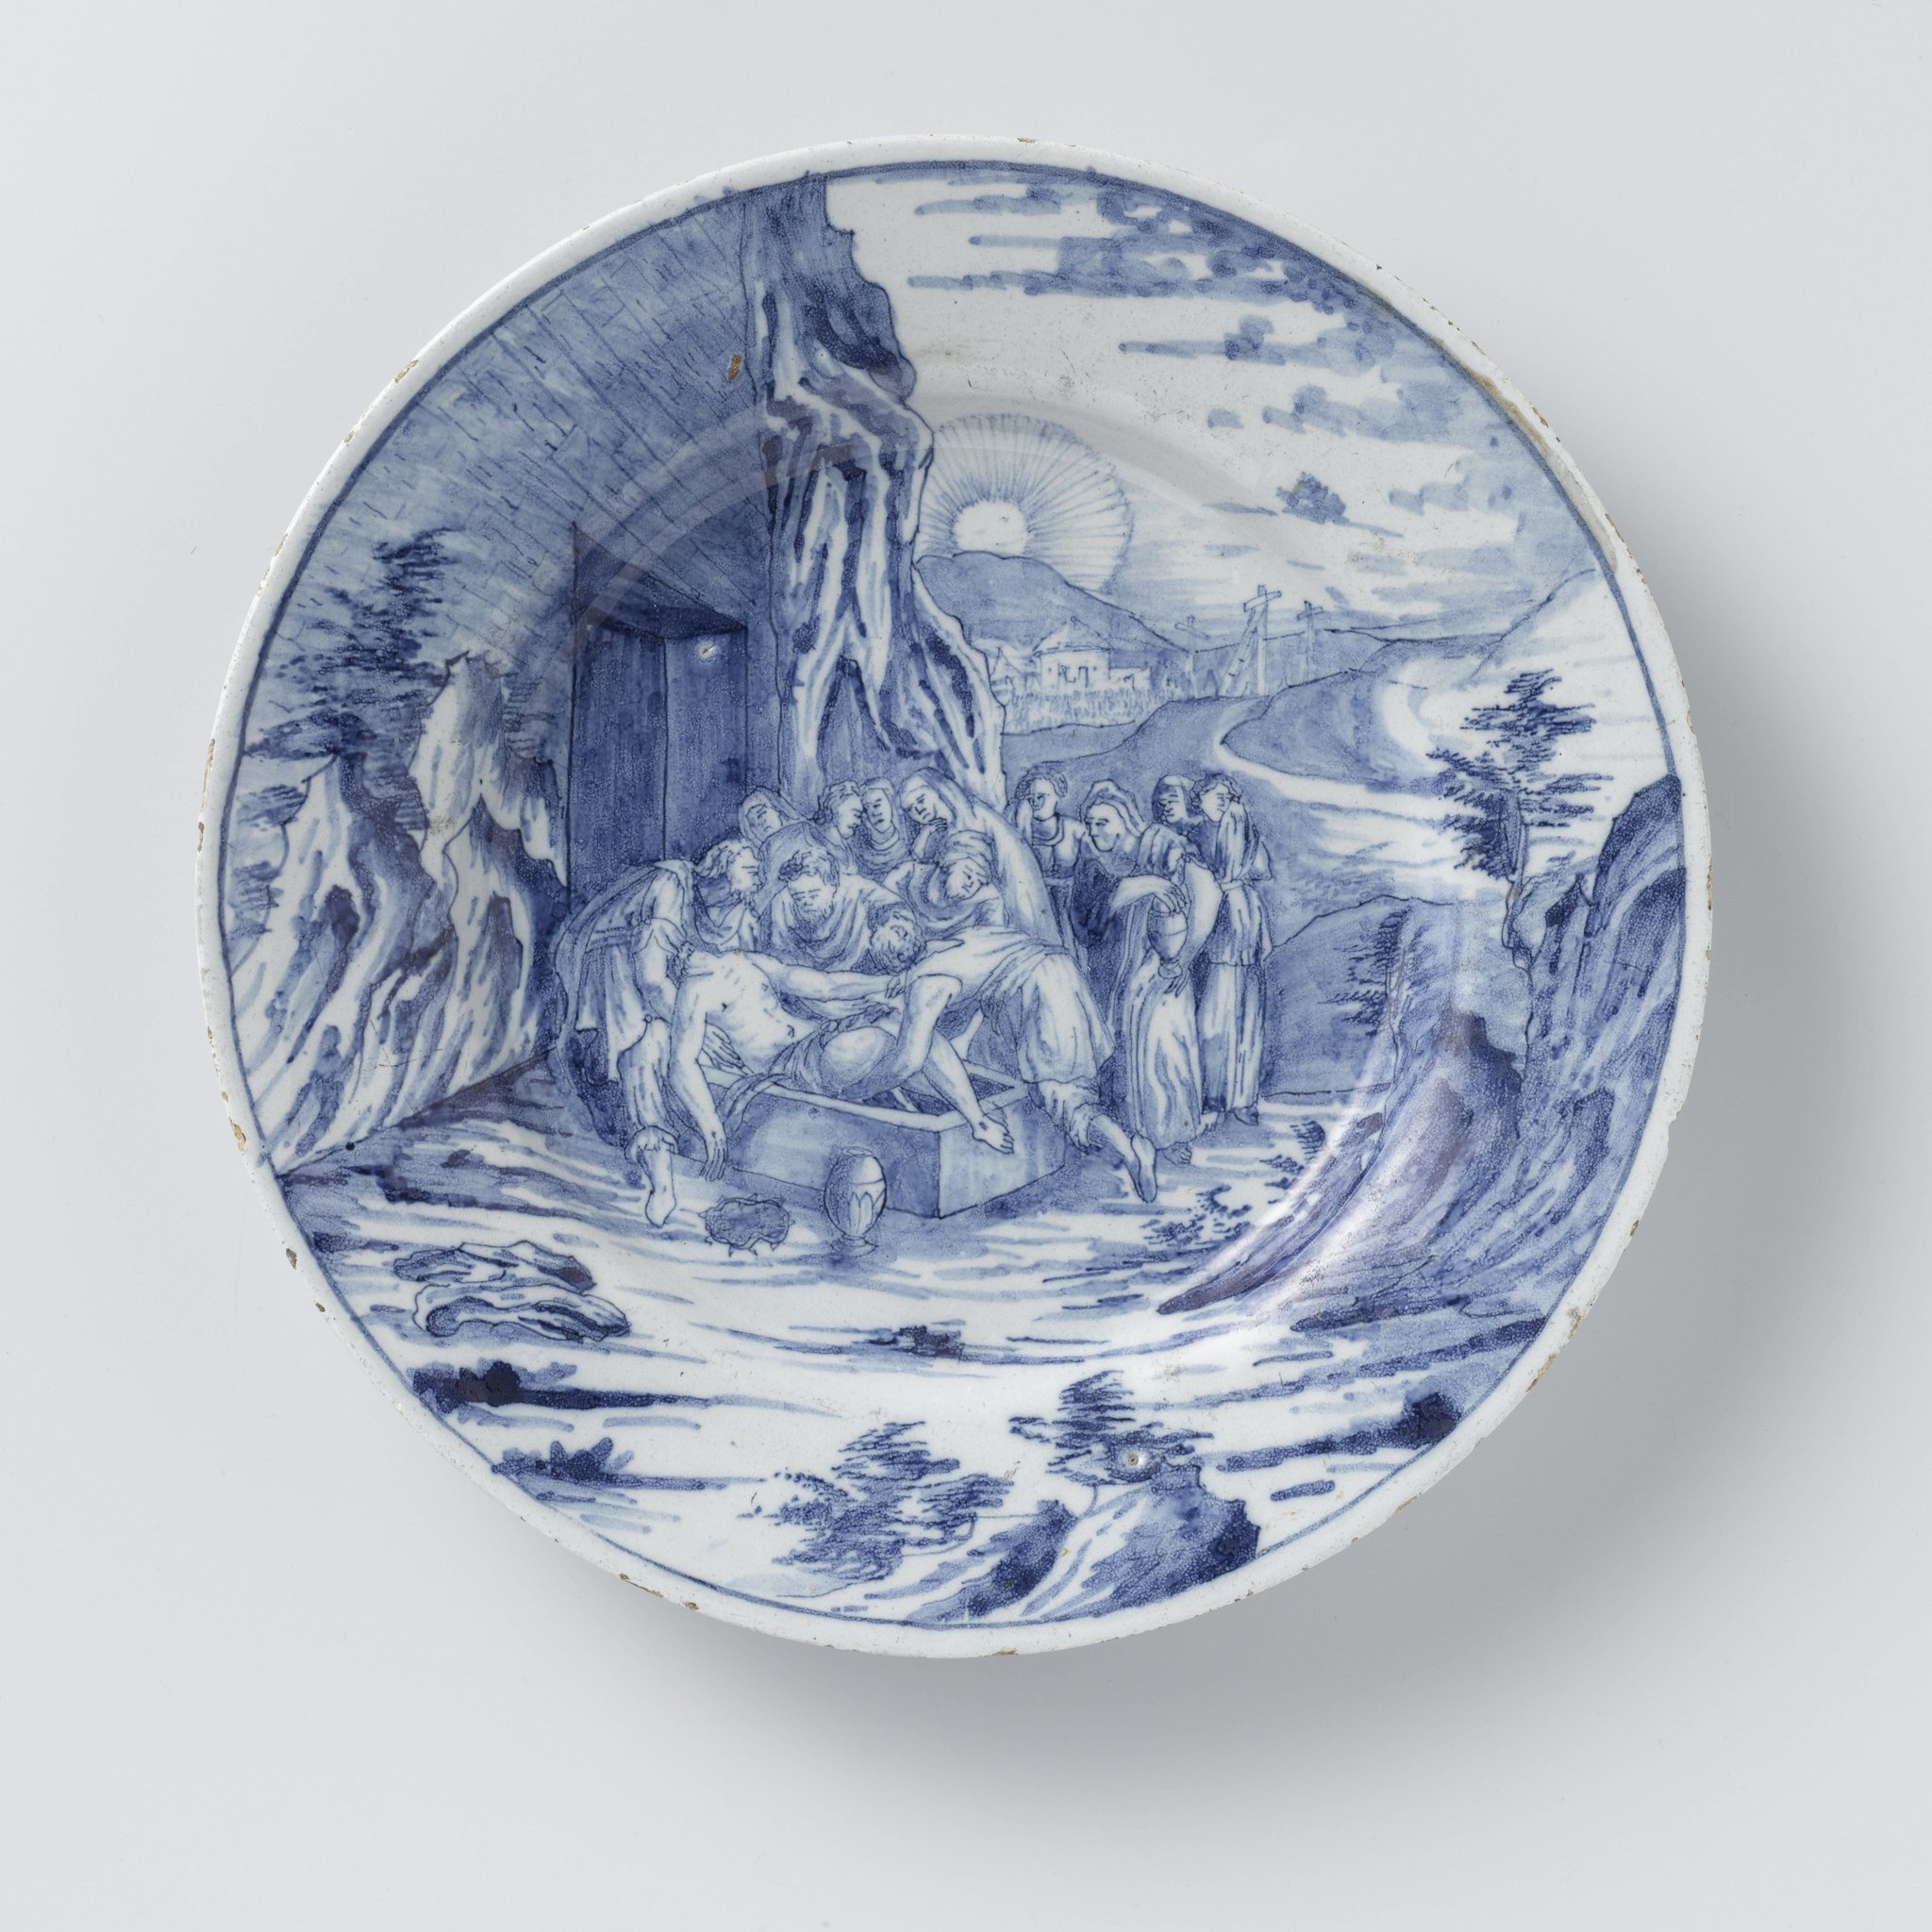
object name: plate dish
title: Bord van faïence met de graflegging van Christus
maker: Anonymous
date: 1750-1775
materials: faience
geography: delft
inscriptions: collector's mark: ‘J.F. Loudon’, seal: ‘302’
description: Bord van aardewerk, blauw beschilderd op tinglazuur met de graflegging van Christus over het gehele oppervlak beschilderd.